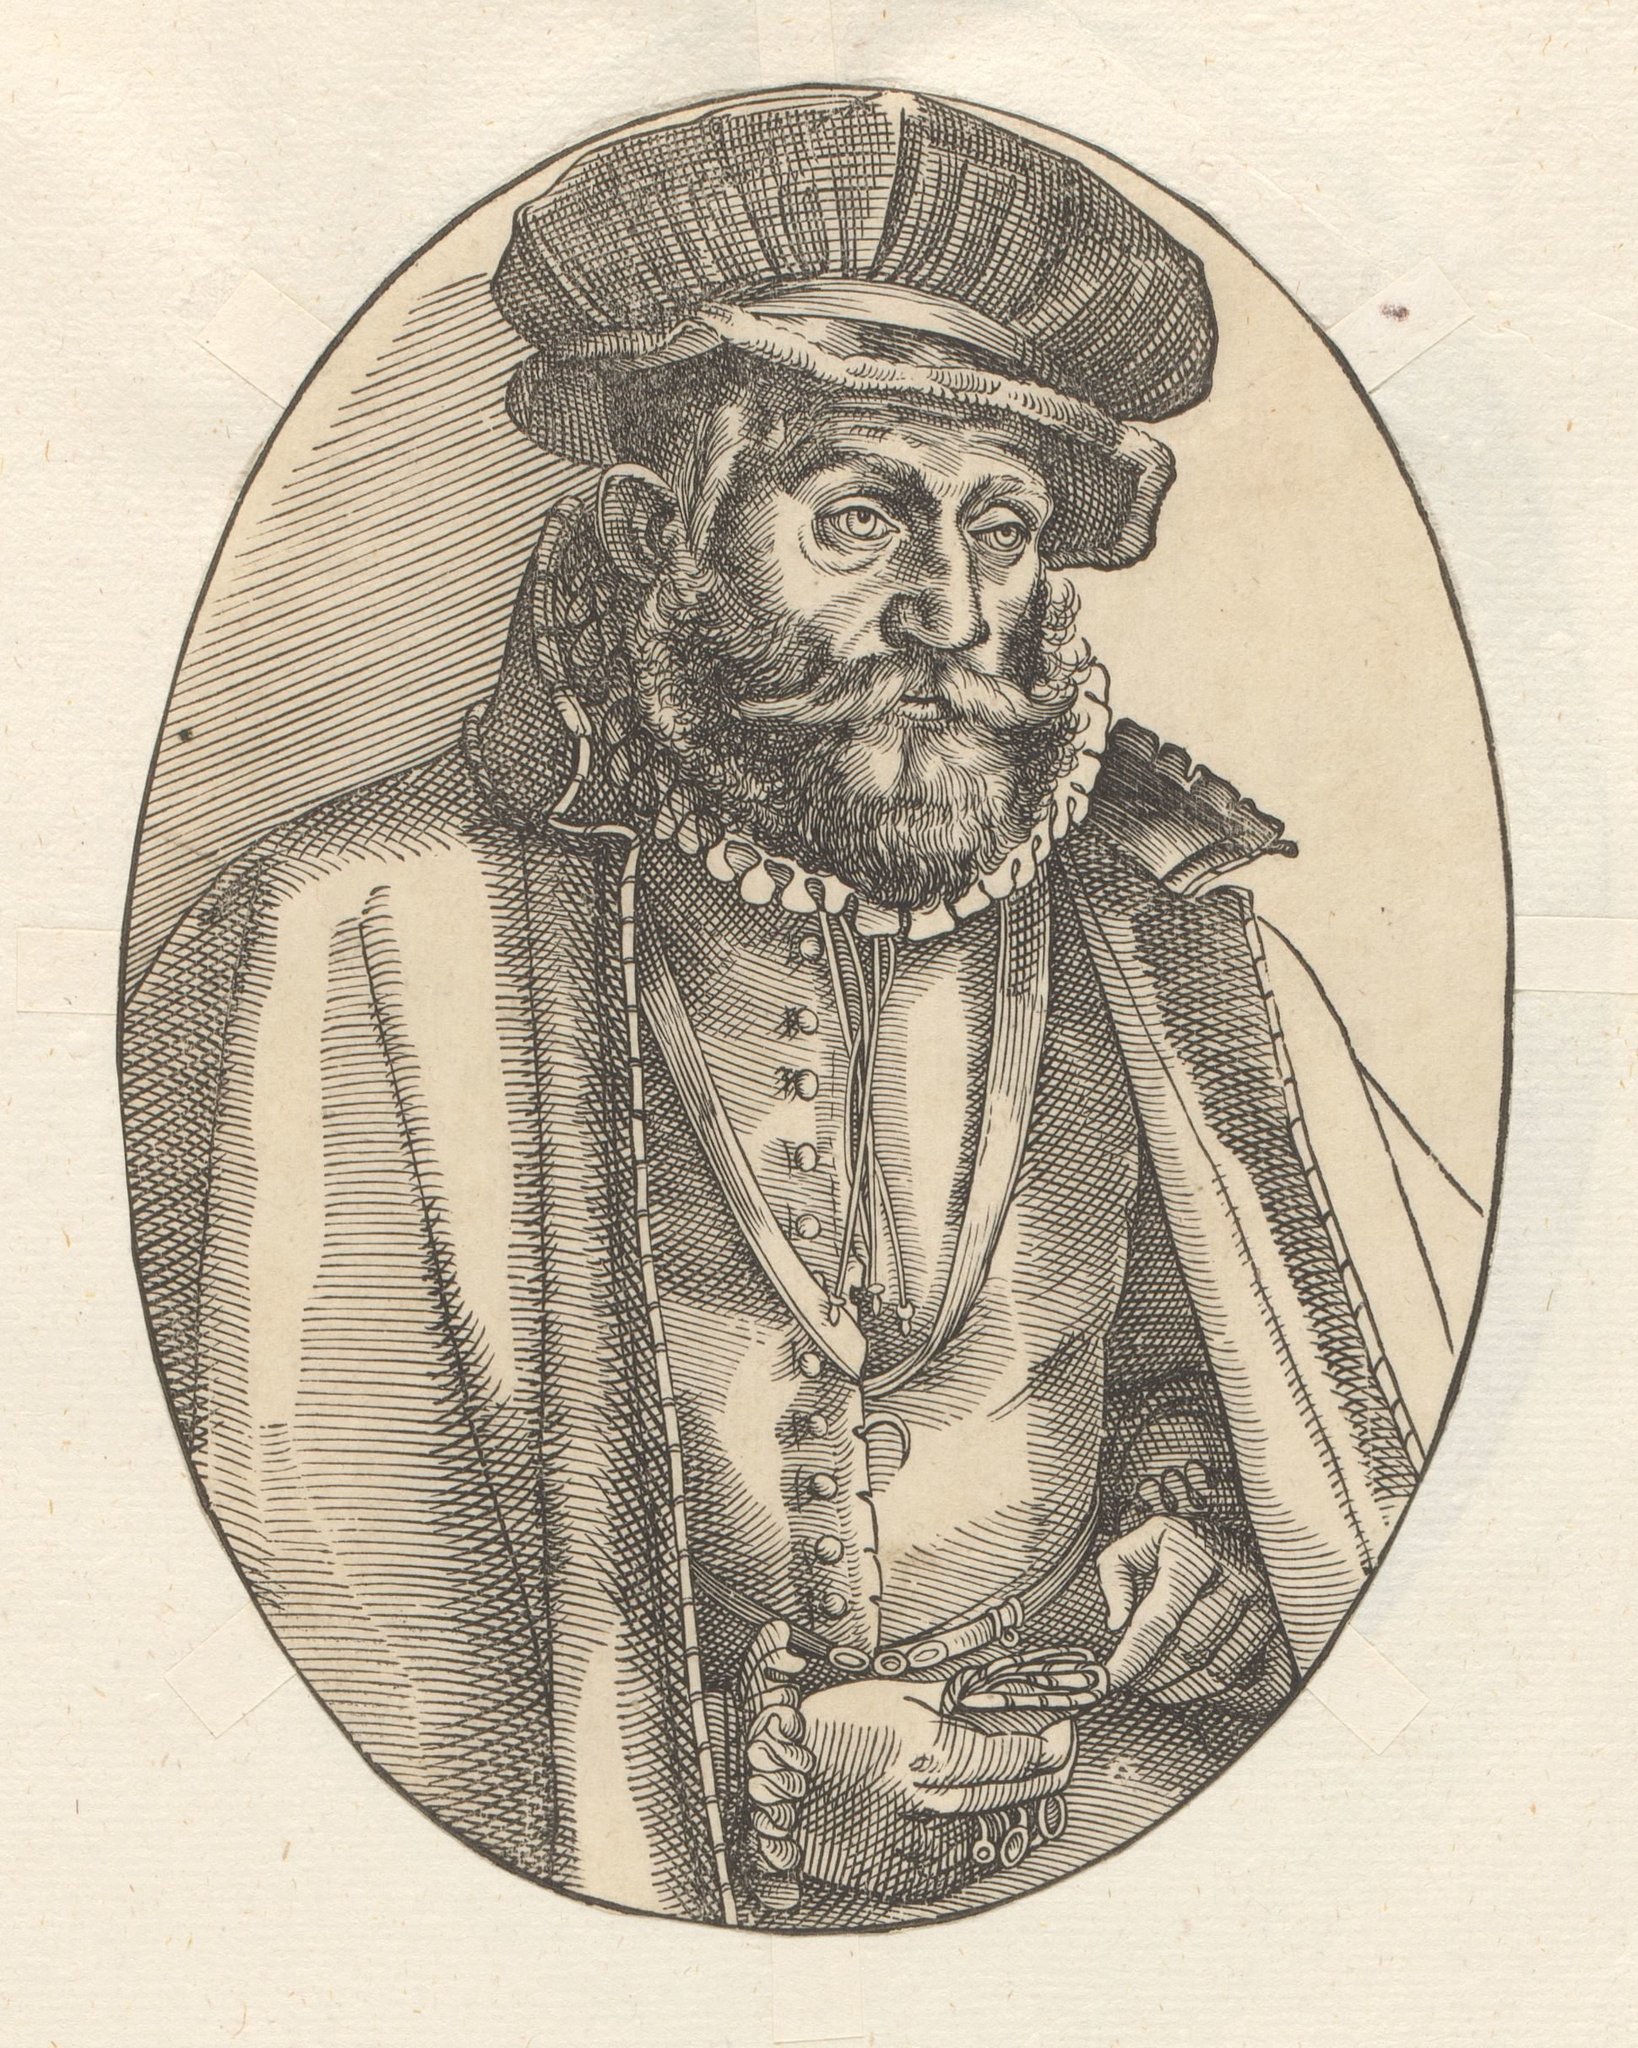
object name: album leaf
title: Portret van Melchior Sebisch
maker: Anonymous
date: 1549-1584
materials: paper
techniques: woodcut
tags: melchior sebisch (i), historical persons